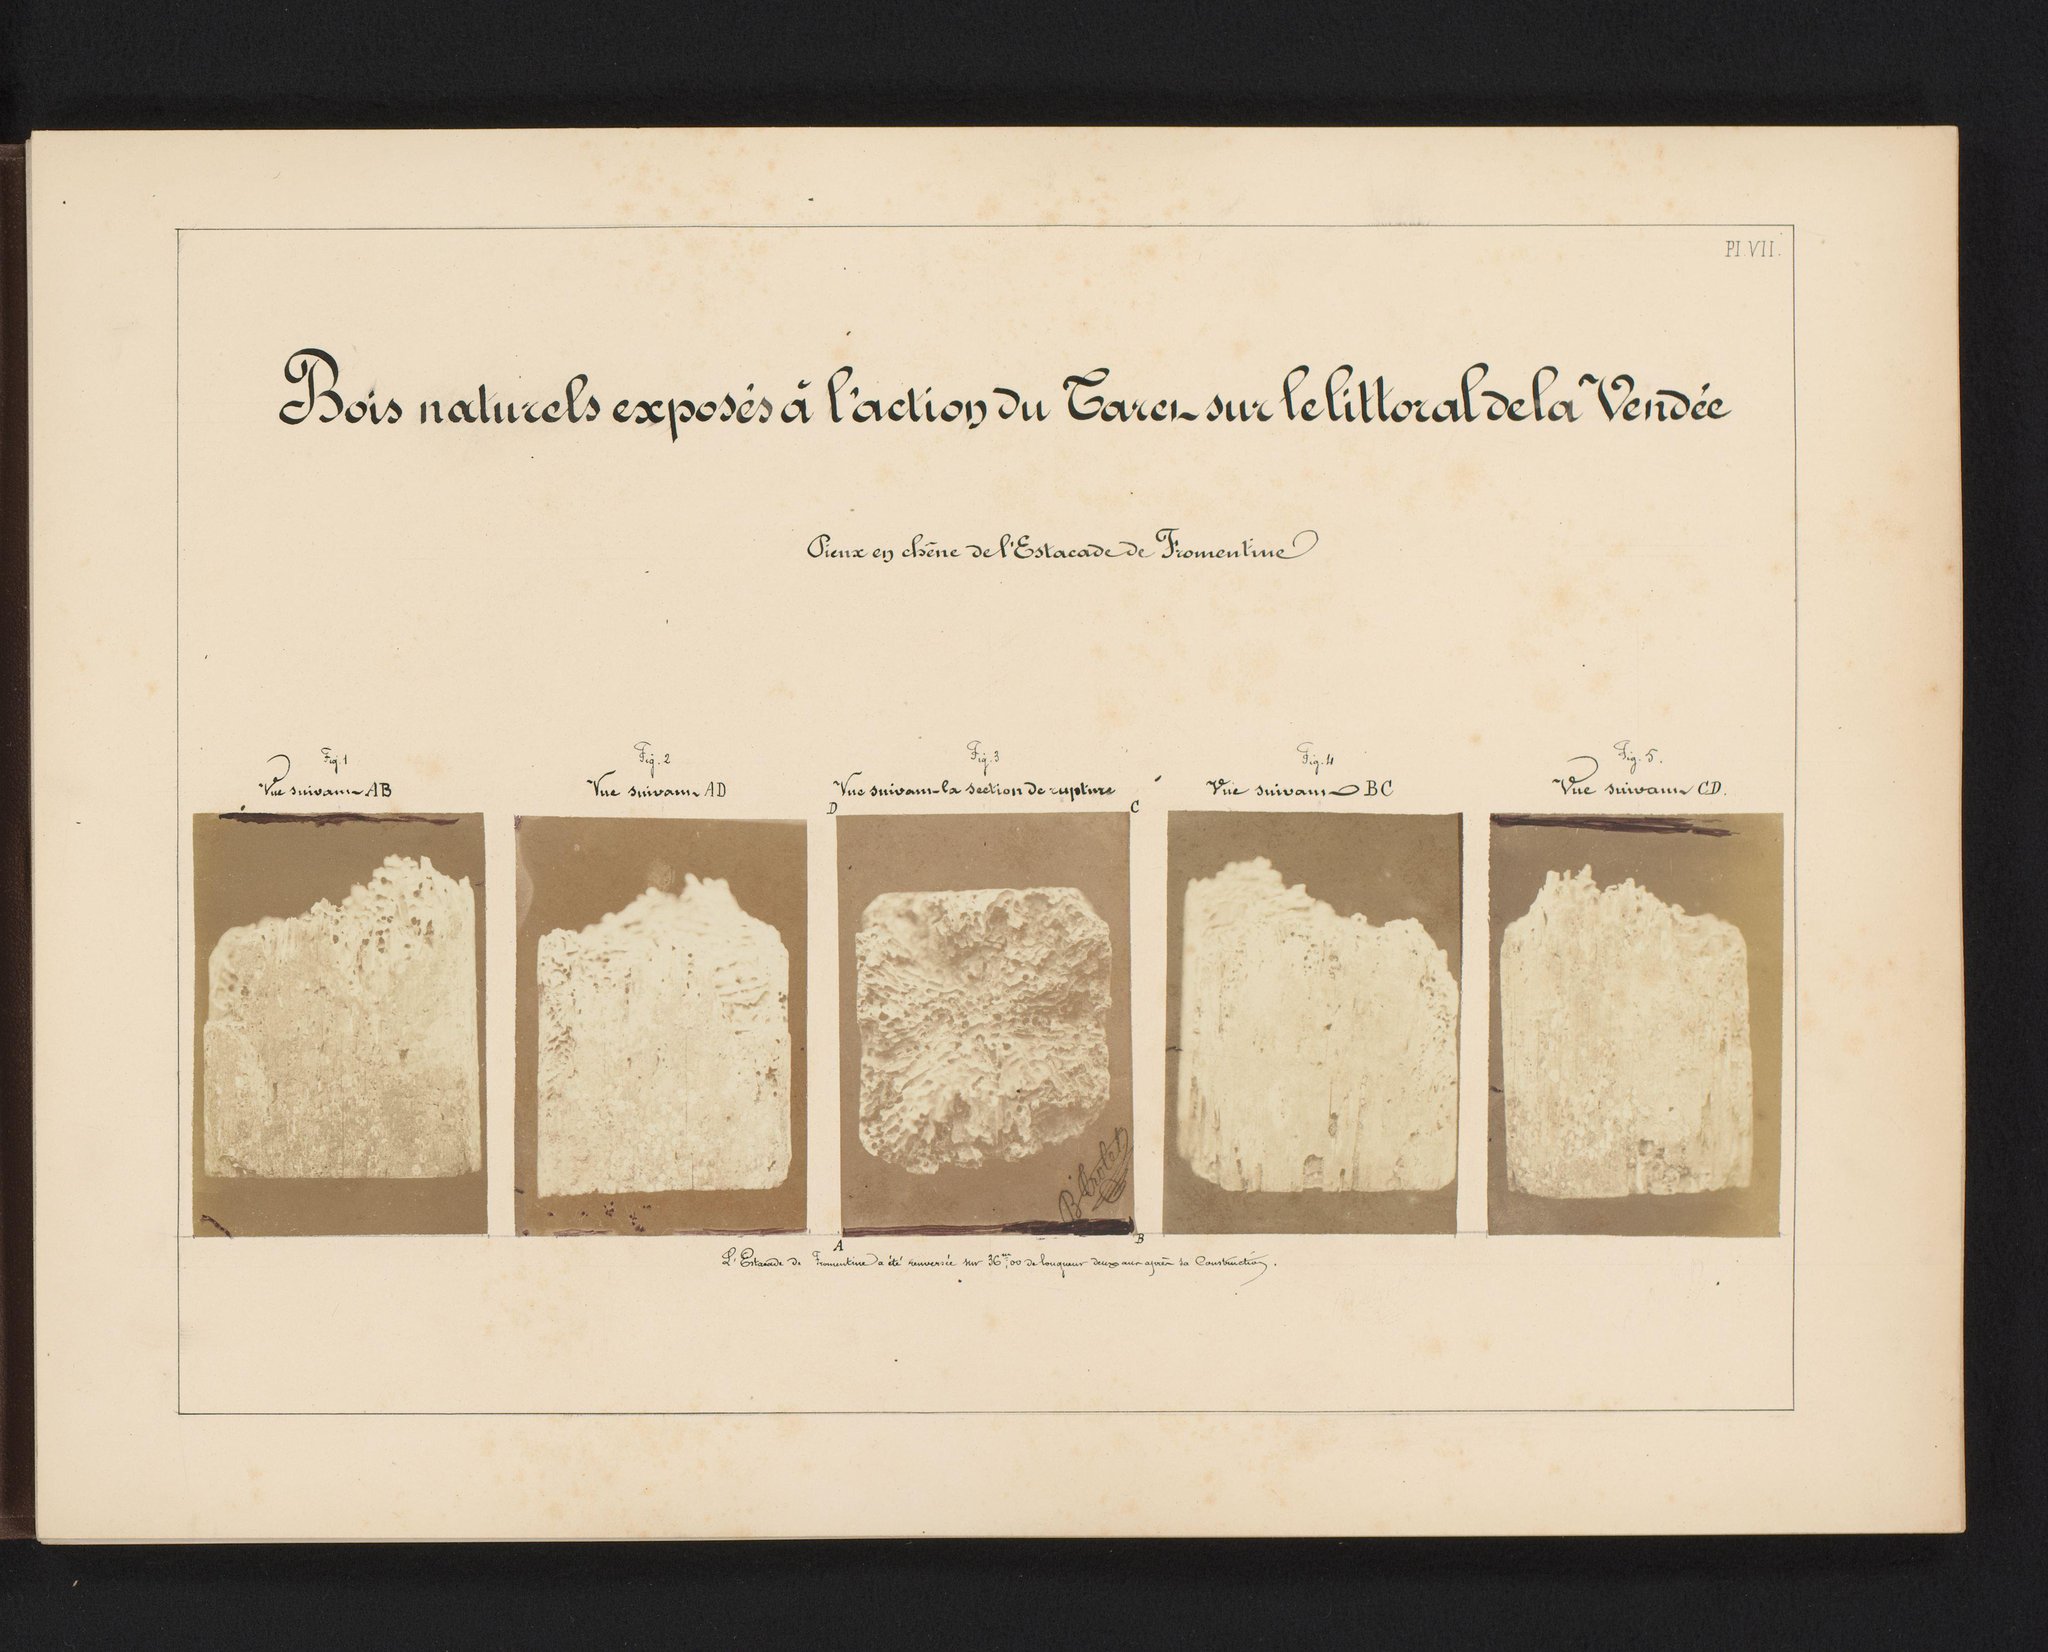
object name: photograph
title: Bois naturels exposés à l'action du Tar[et] sur le littoral de la Vendée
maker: b. crolet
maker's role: fotograaf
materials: cardboard, photographic support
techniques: albumen print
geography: france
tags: worms, wood, timber ~ building material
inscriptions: signature: ‘B. Crolet’, annotation: ‘Pieux en chêne de l'Estade de Fromentine/ (...) la Construction.’, number: ‘Pl. VII.’